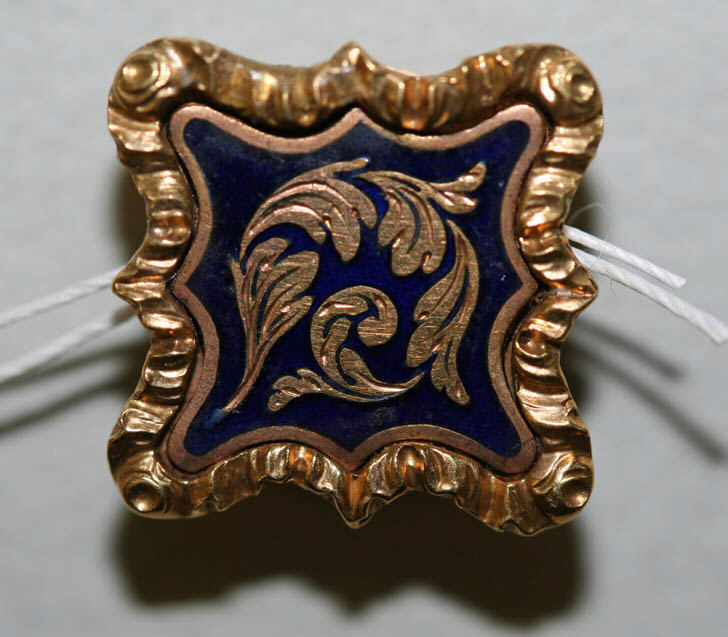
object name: stud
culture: french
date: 1701-1900